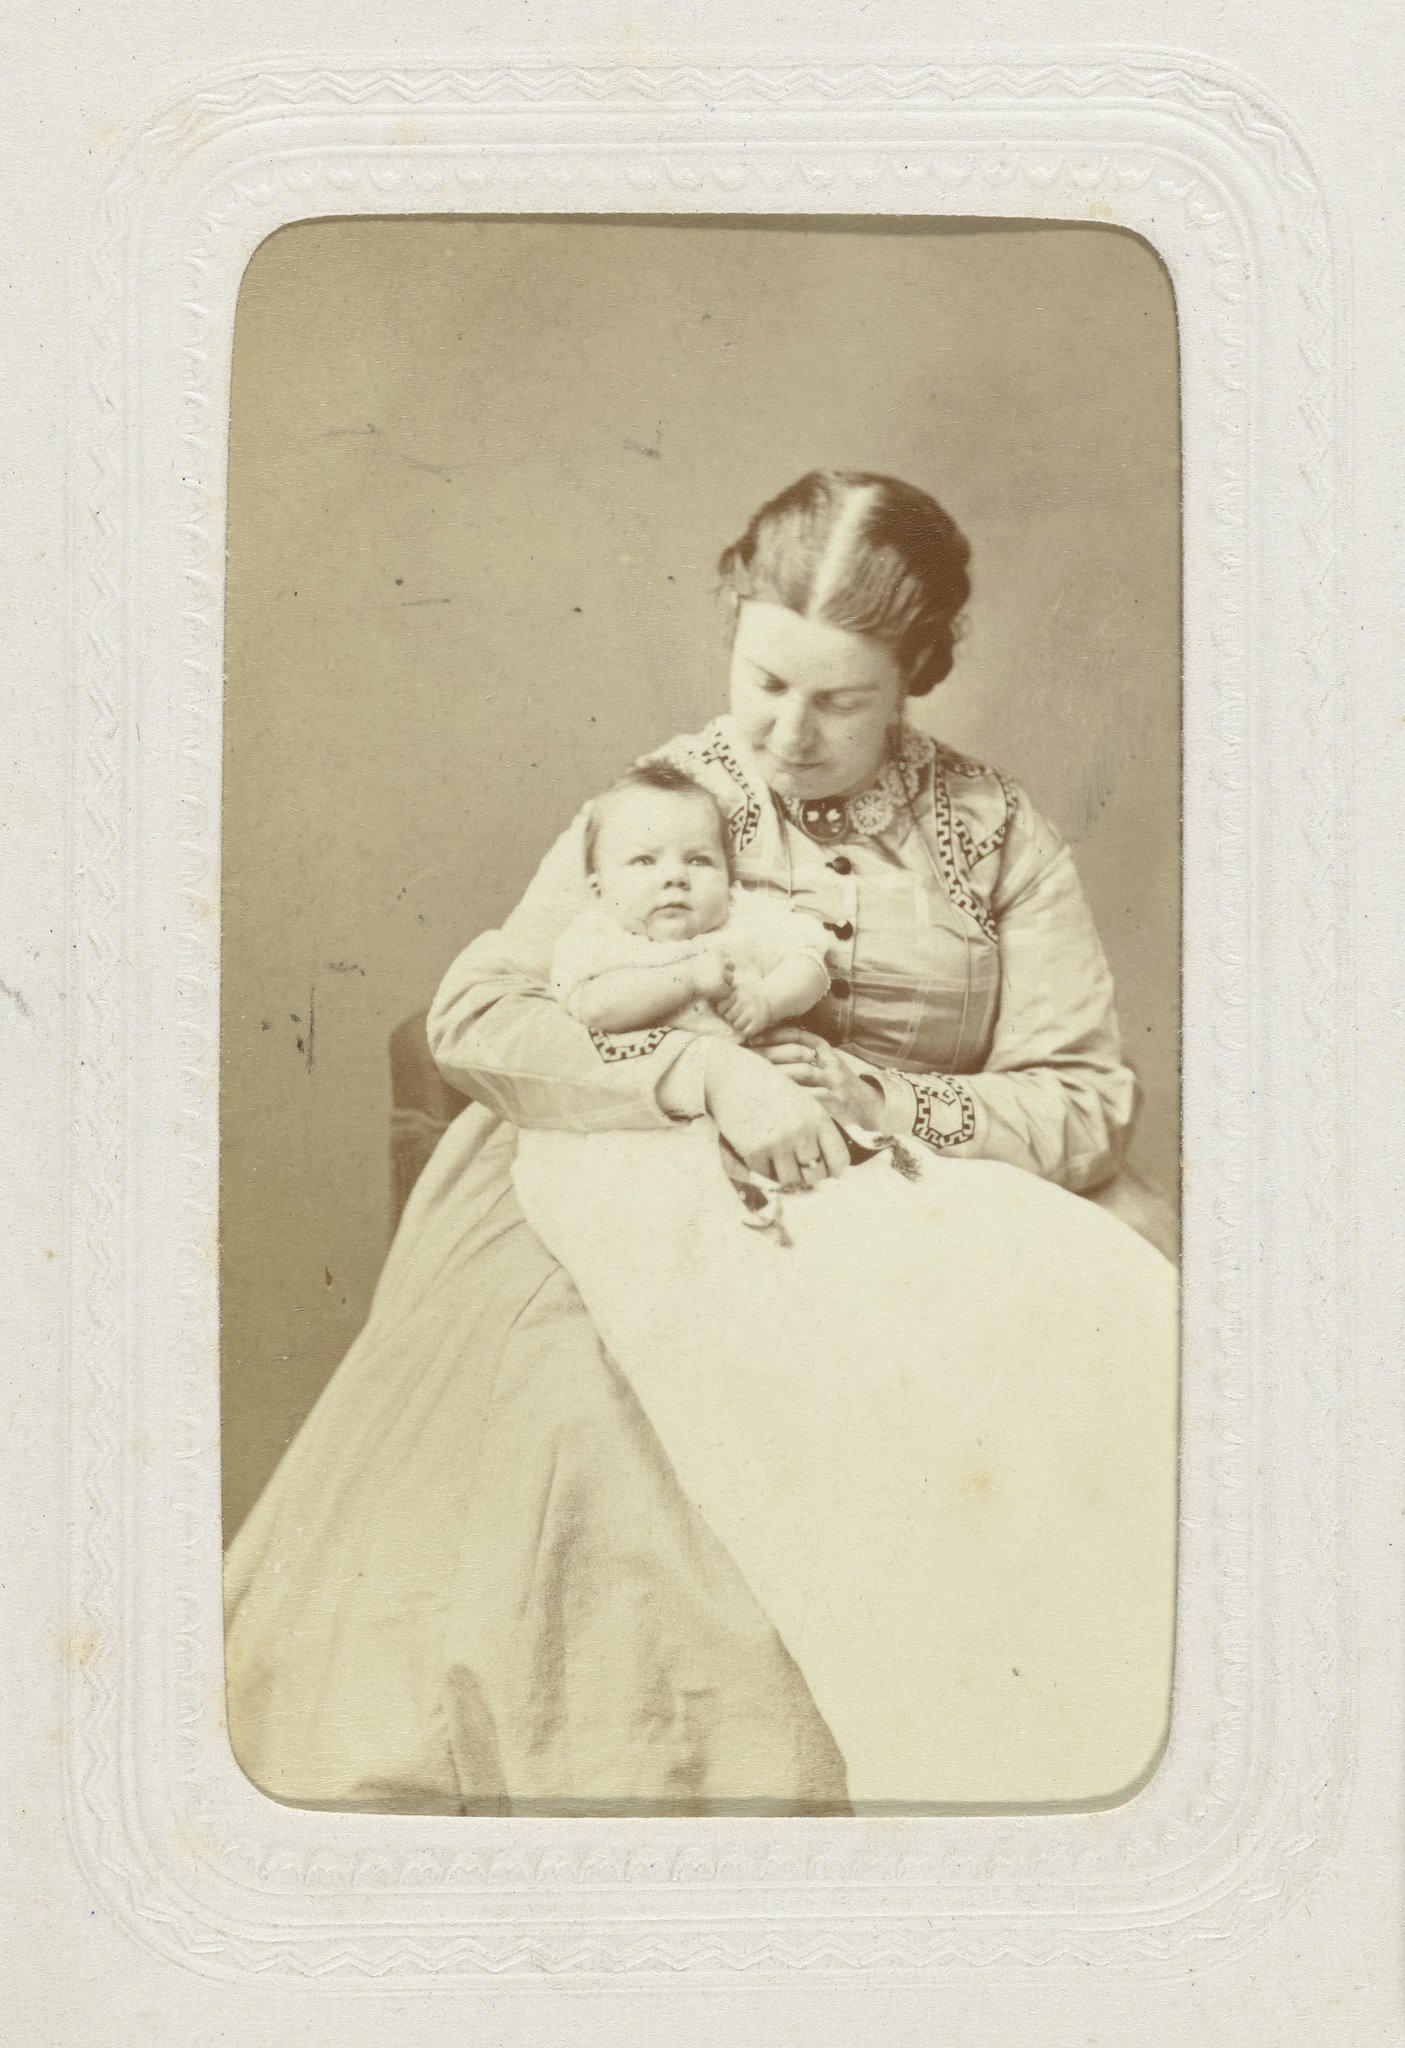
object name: carte de visite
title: Studioportret van een vrouw met een baby in witte jurk op schoot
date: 1863-1870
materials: cardboard, paper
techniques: albumen print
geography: amsterdam